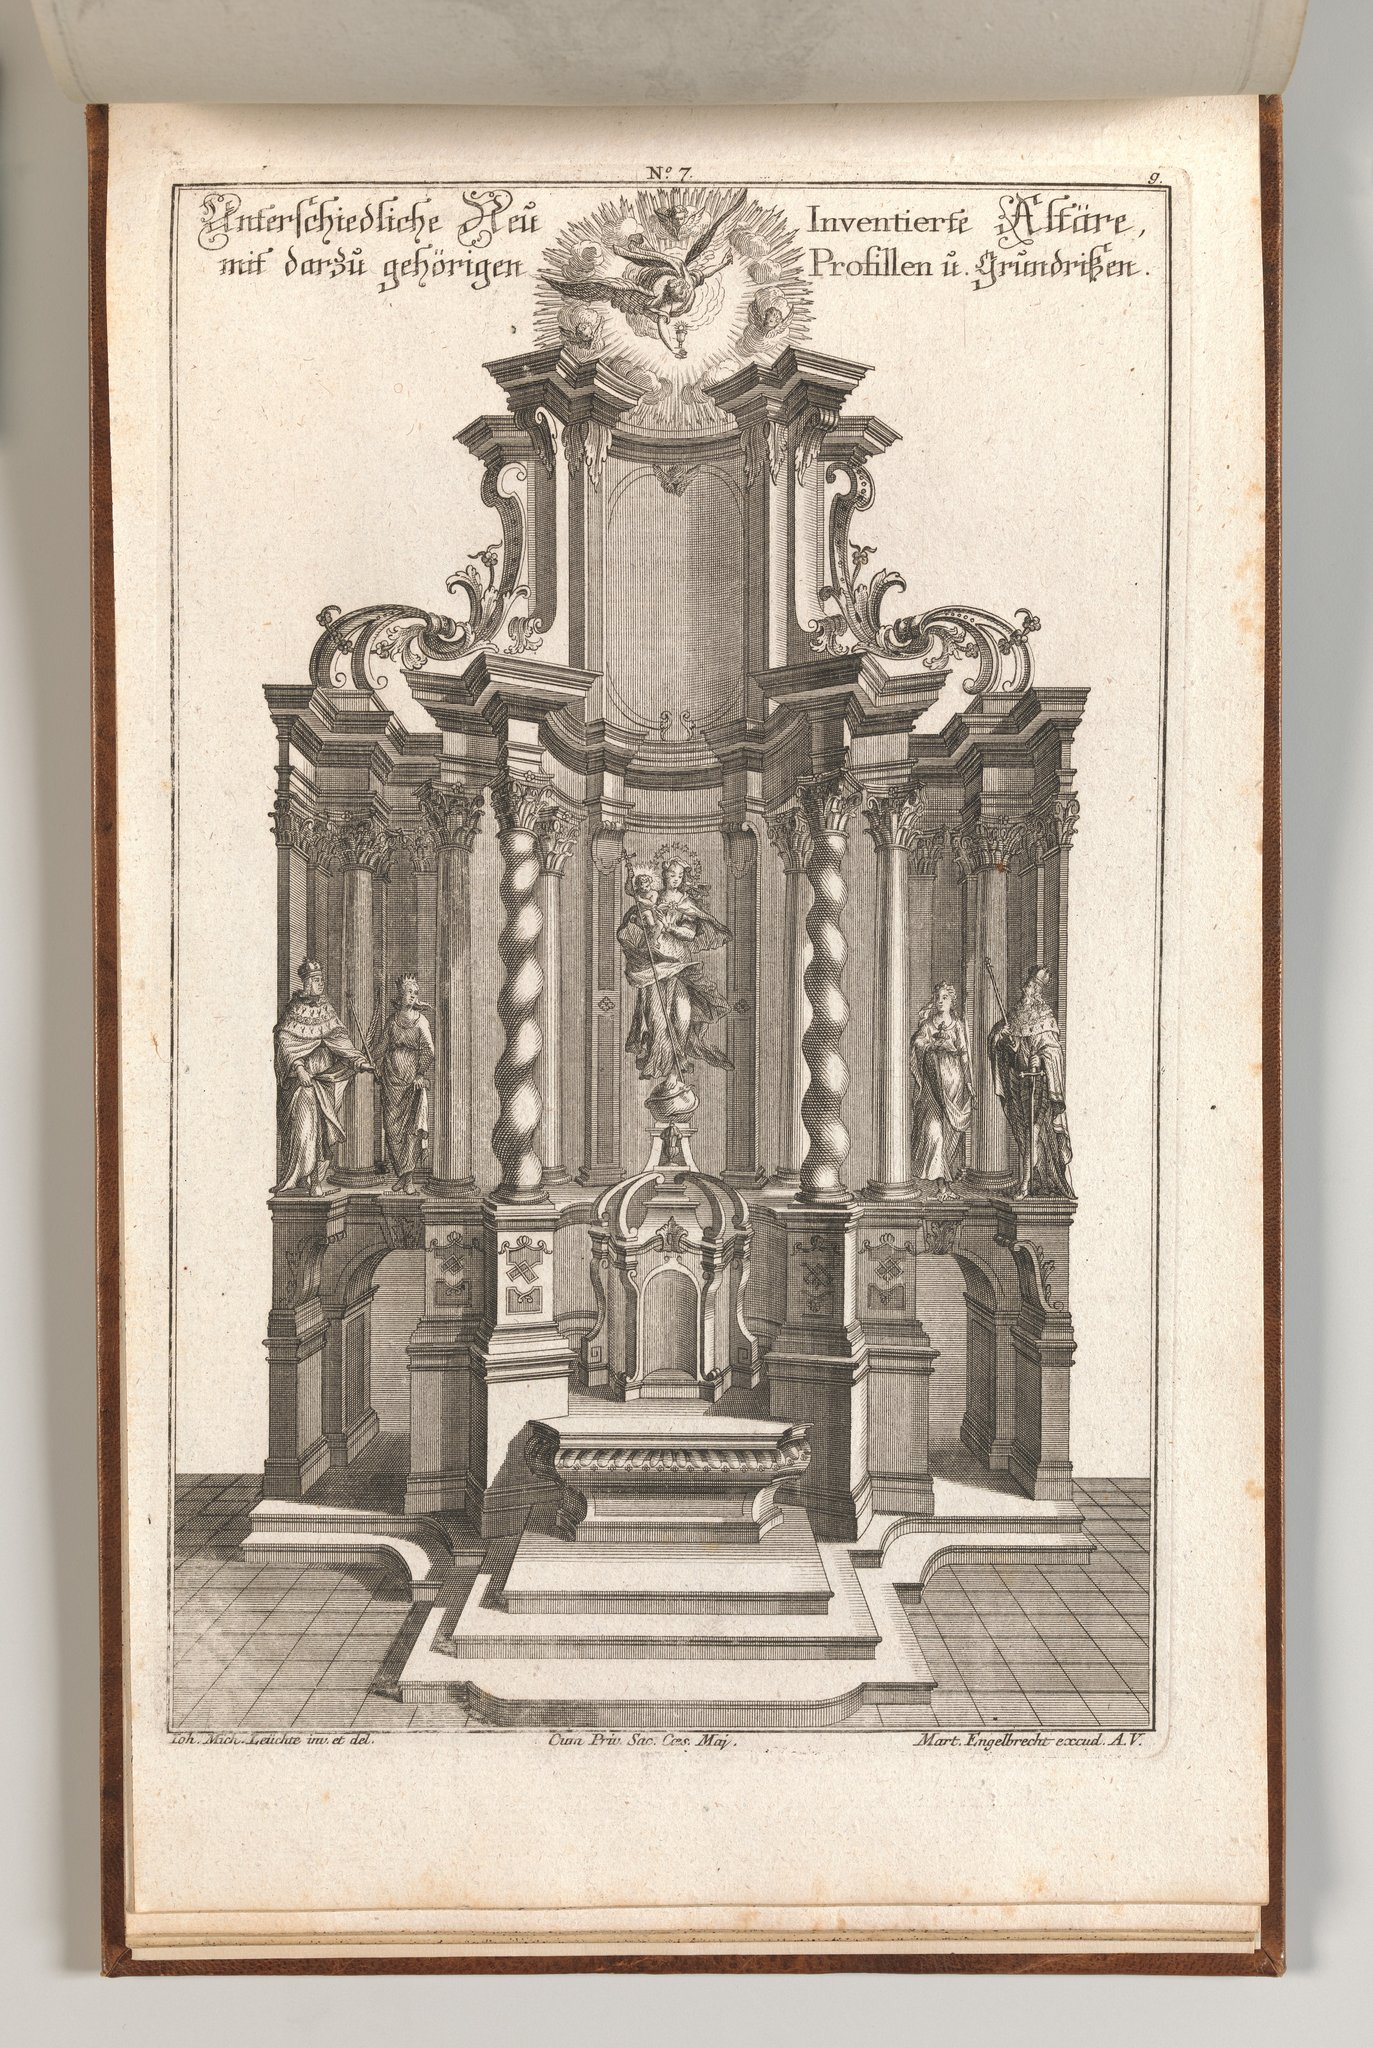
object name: album print ornament architecture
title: Design for a Monumental Altar, Plate g from 'Unterschiedliche Neu Inventierte Altäre mit darzu gehörigen Profillen u. Grundrißen.'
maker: johann michael leüchte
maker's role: artist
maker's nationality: german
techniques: etching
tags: altars,ornament